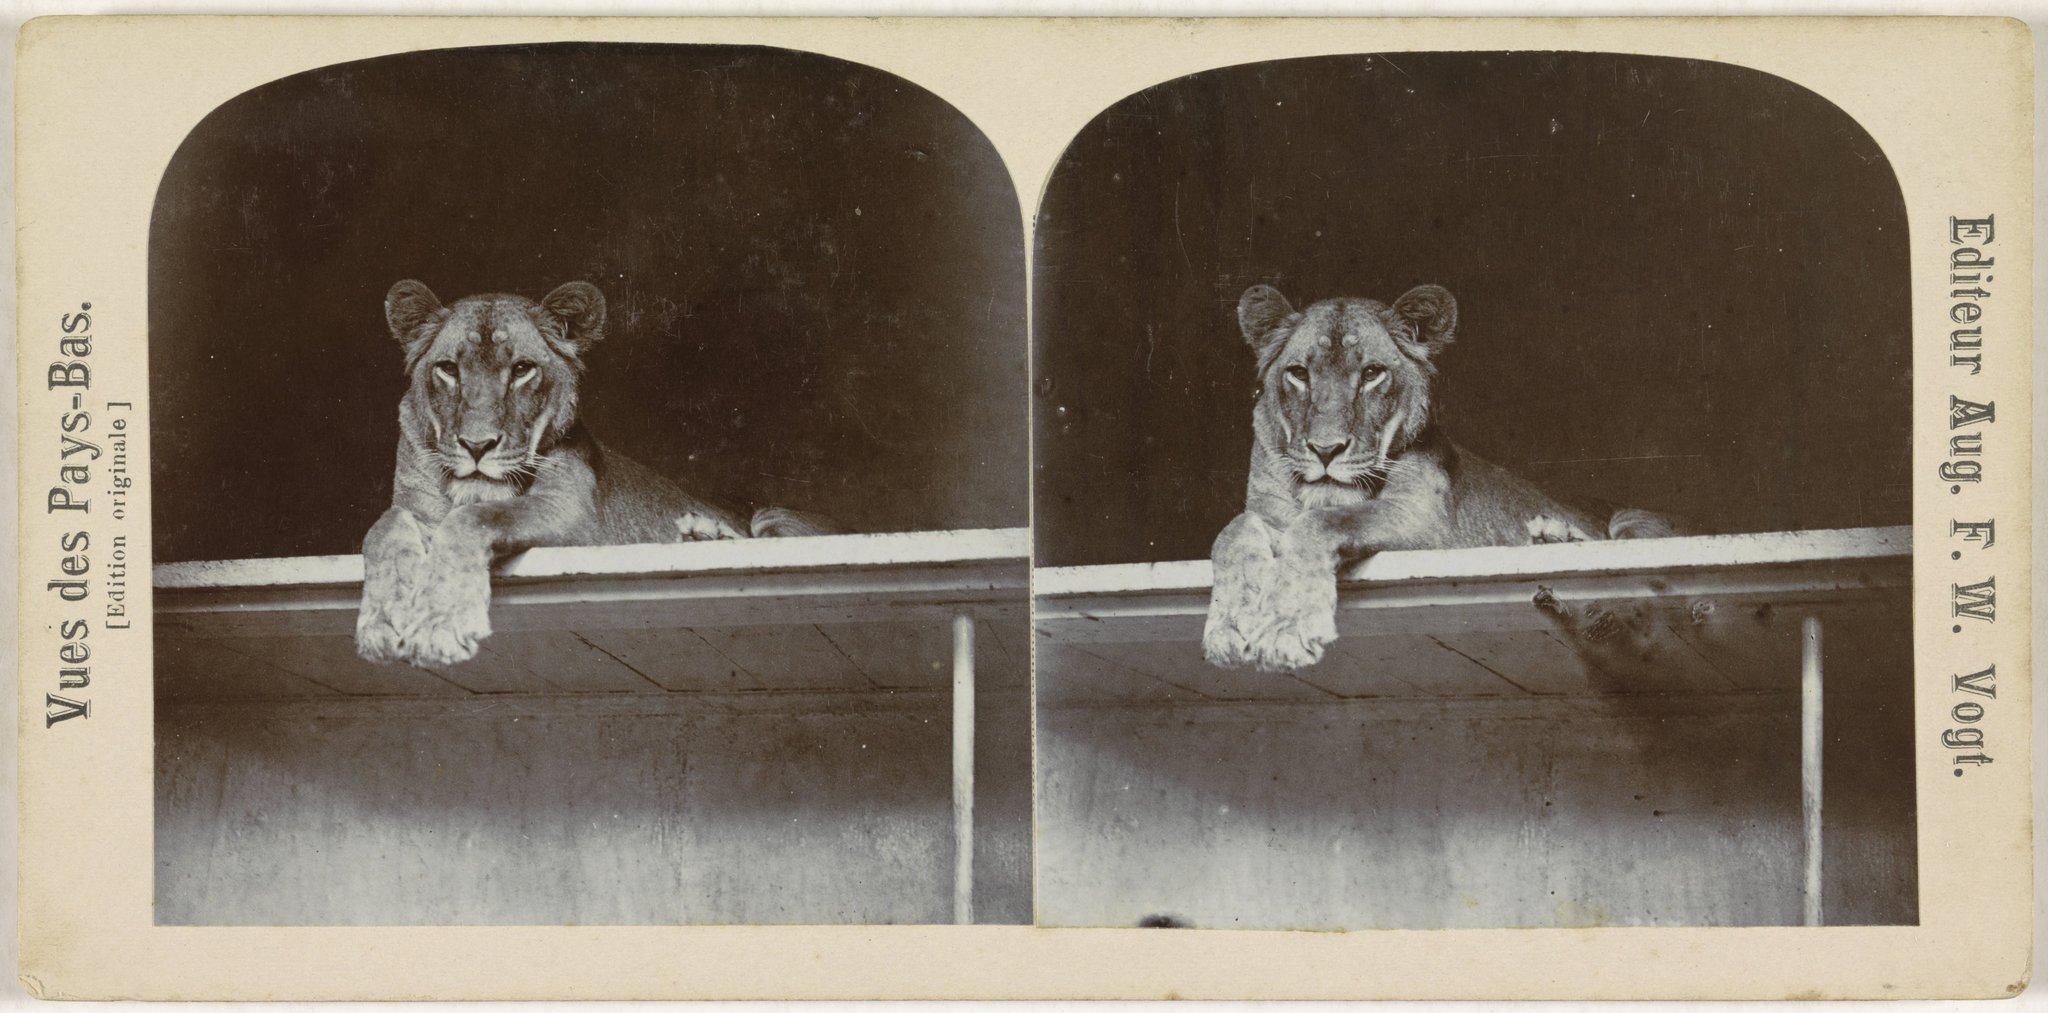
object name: stereograph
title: Vues des Pays-Bas. [Edition originale]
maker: august frederik willem vogt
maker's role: fotograaf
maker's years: 1871-1922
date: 1920-1940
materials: cardboard, paper, photographic support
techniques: gelatin silver print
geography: netherlands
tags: netherlands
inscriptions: inscription: ‘€10,-’